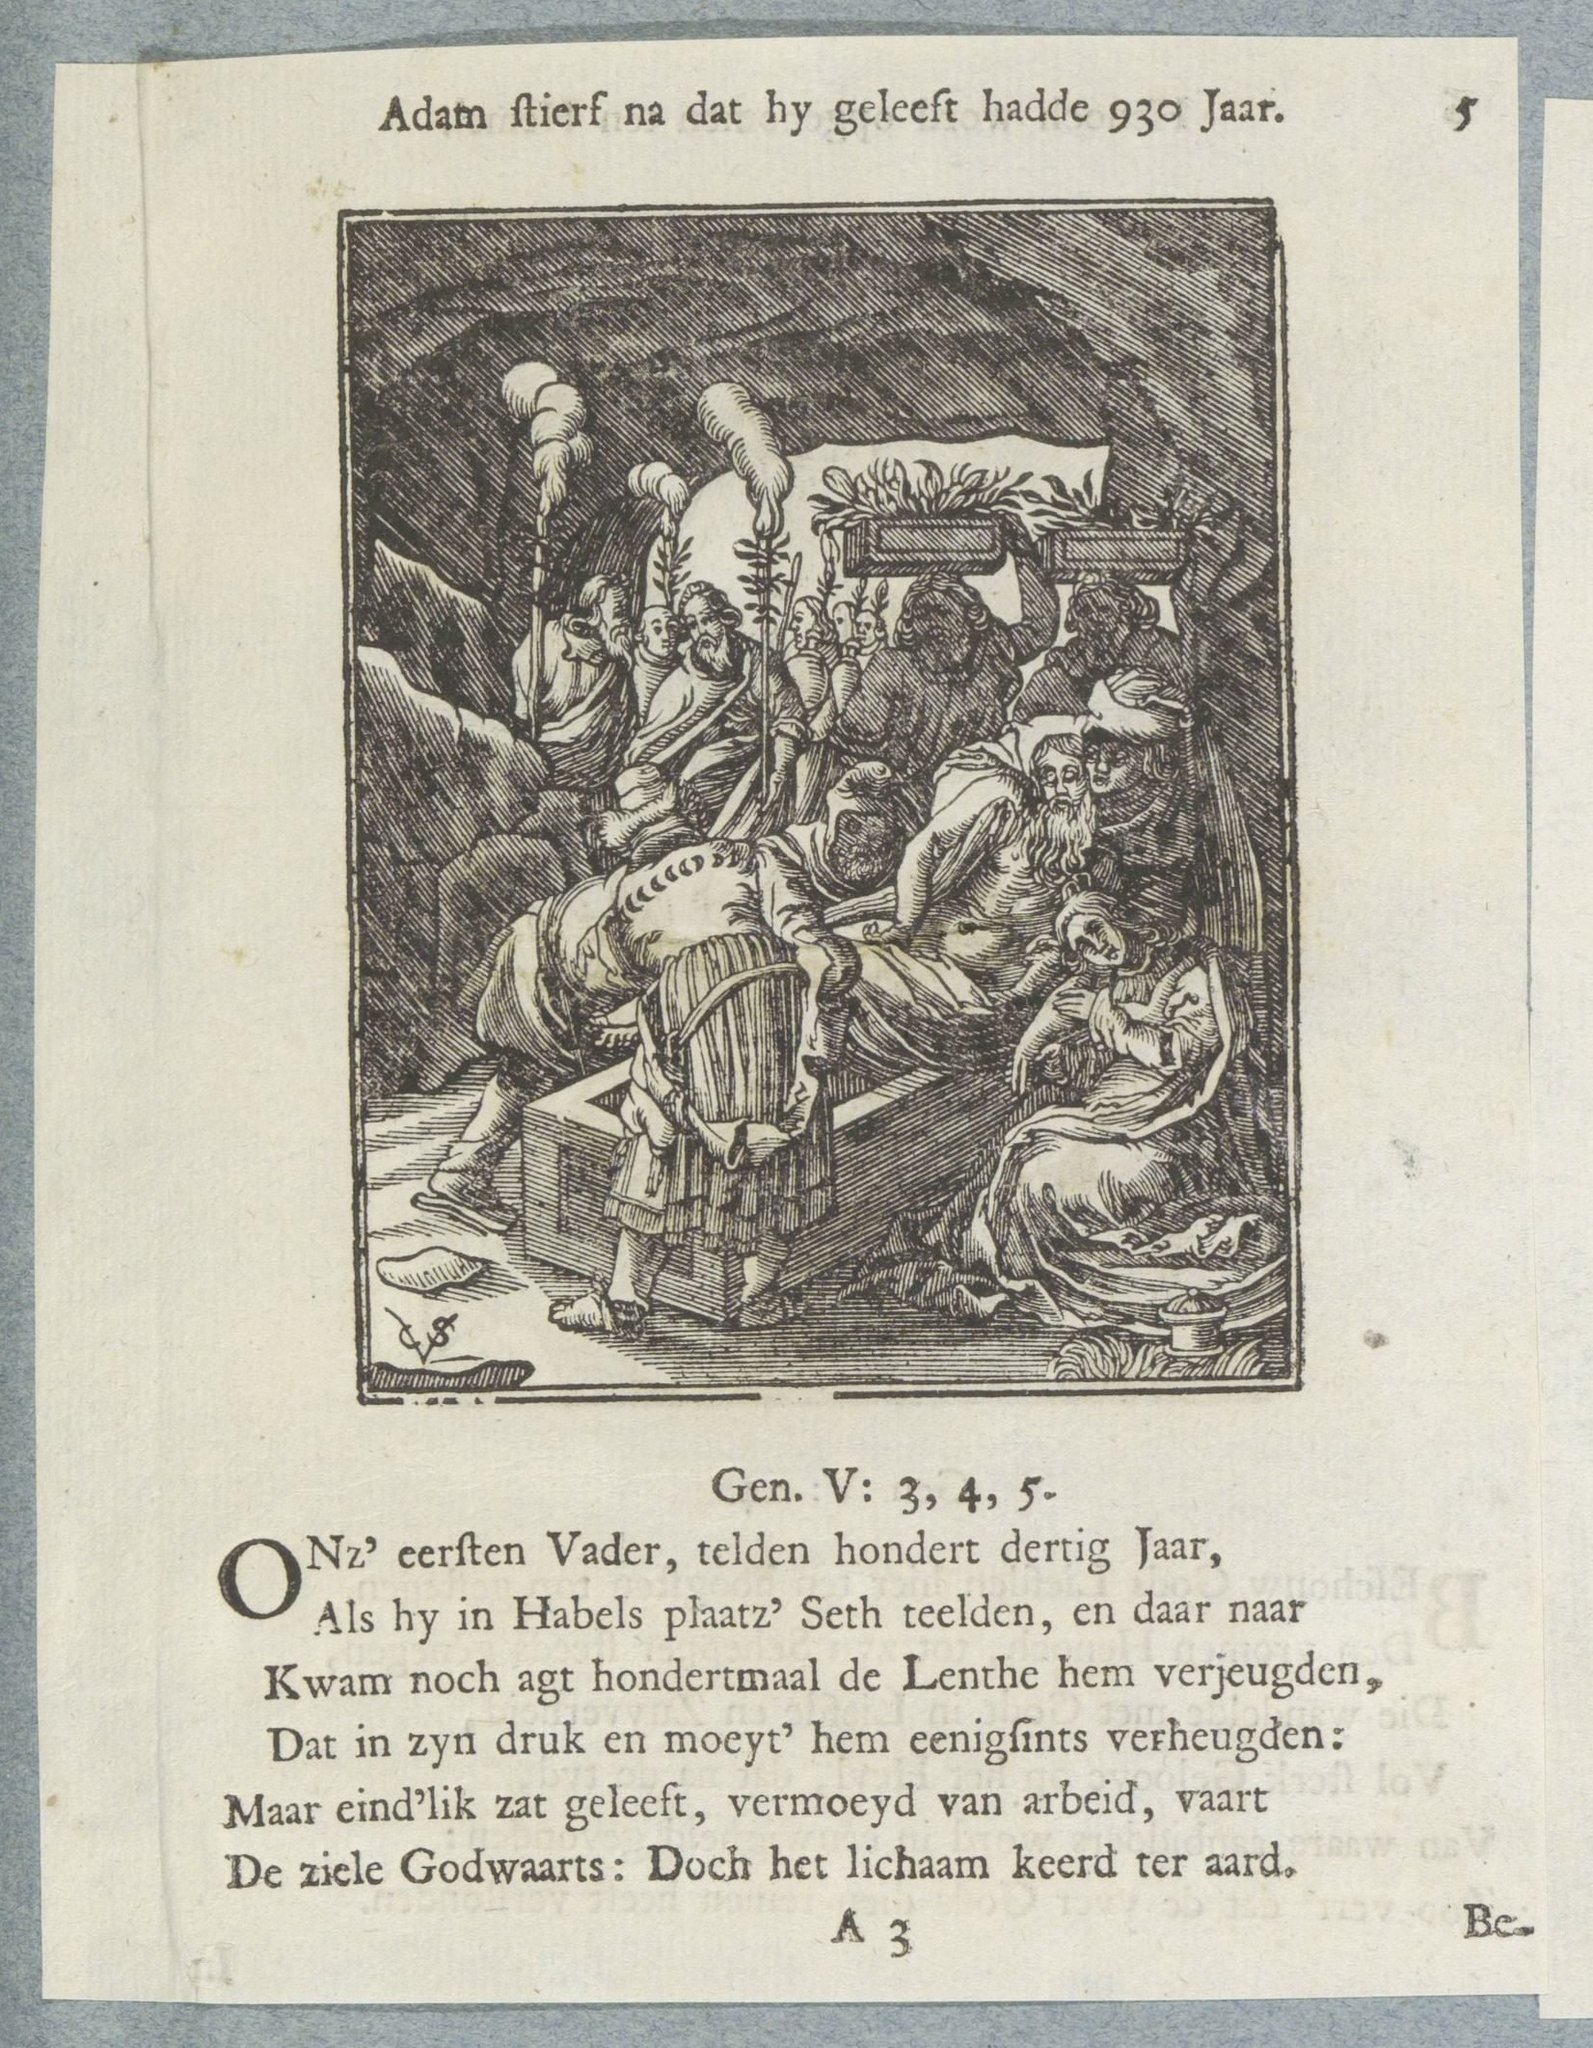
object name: album leaf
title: Begrafenis van Adam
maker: jan klooster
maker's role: bookseller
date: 1740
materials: paper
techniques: letterpress printing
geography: haarlem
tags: christ's entombment (possibly by angels), adam's burial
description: De prent is afkomstig uit: Bybels Lusthof. Amsterdam, J. Klooster, 1740. De prent werd gemaakt voor de uitgaven van P.J. Paets uit Amsterdam. Ze komt in ieder geval voor in: Bibels Tresoor ofte der zielen lusthof. Amsterdam, P.J. Paets, 1646 en Biblia Sacra. Amsterdam, P.J. Paets, 1657. Mogelijk staat ze ook in: Historien ende Prophetien. [Amsterdam], P.J. Paets, 1645. De achtergrond van de voorstelling is een kopie van een prent van Johann (I) Sadeler naar Maarten de Vos. De voorgrond gaat terug op de Graflegging van Christus gegraveerd door Hendrick Goltzius.